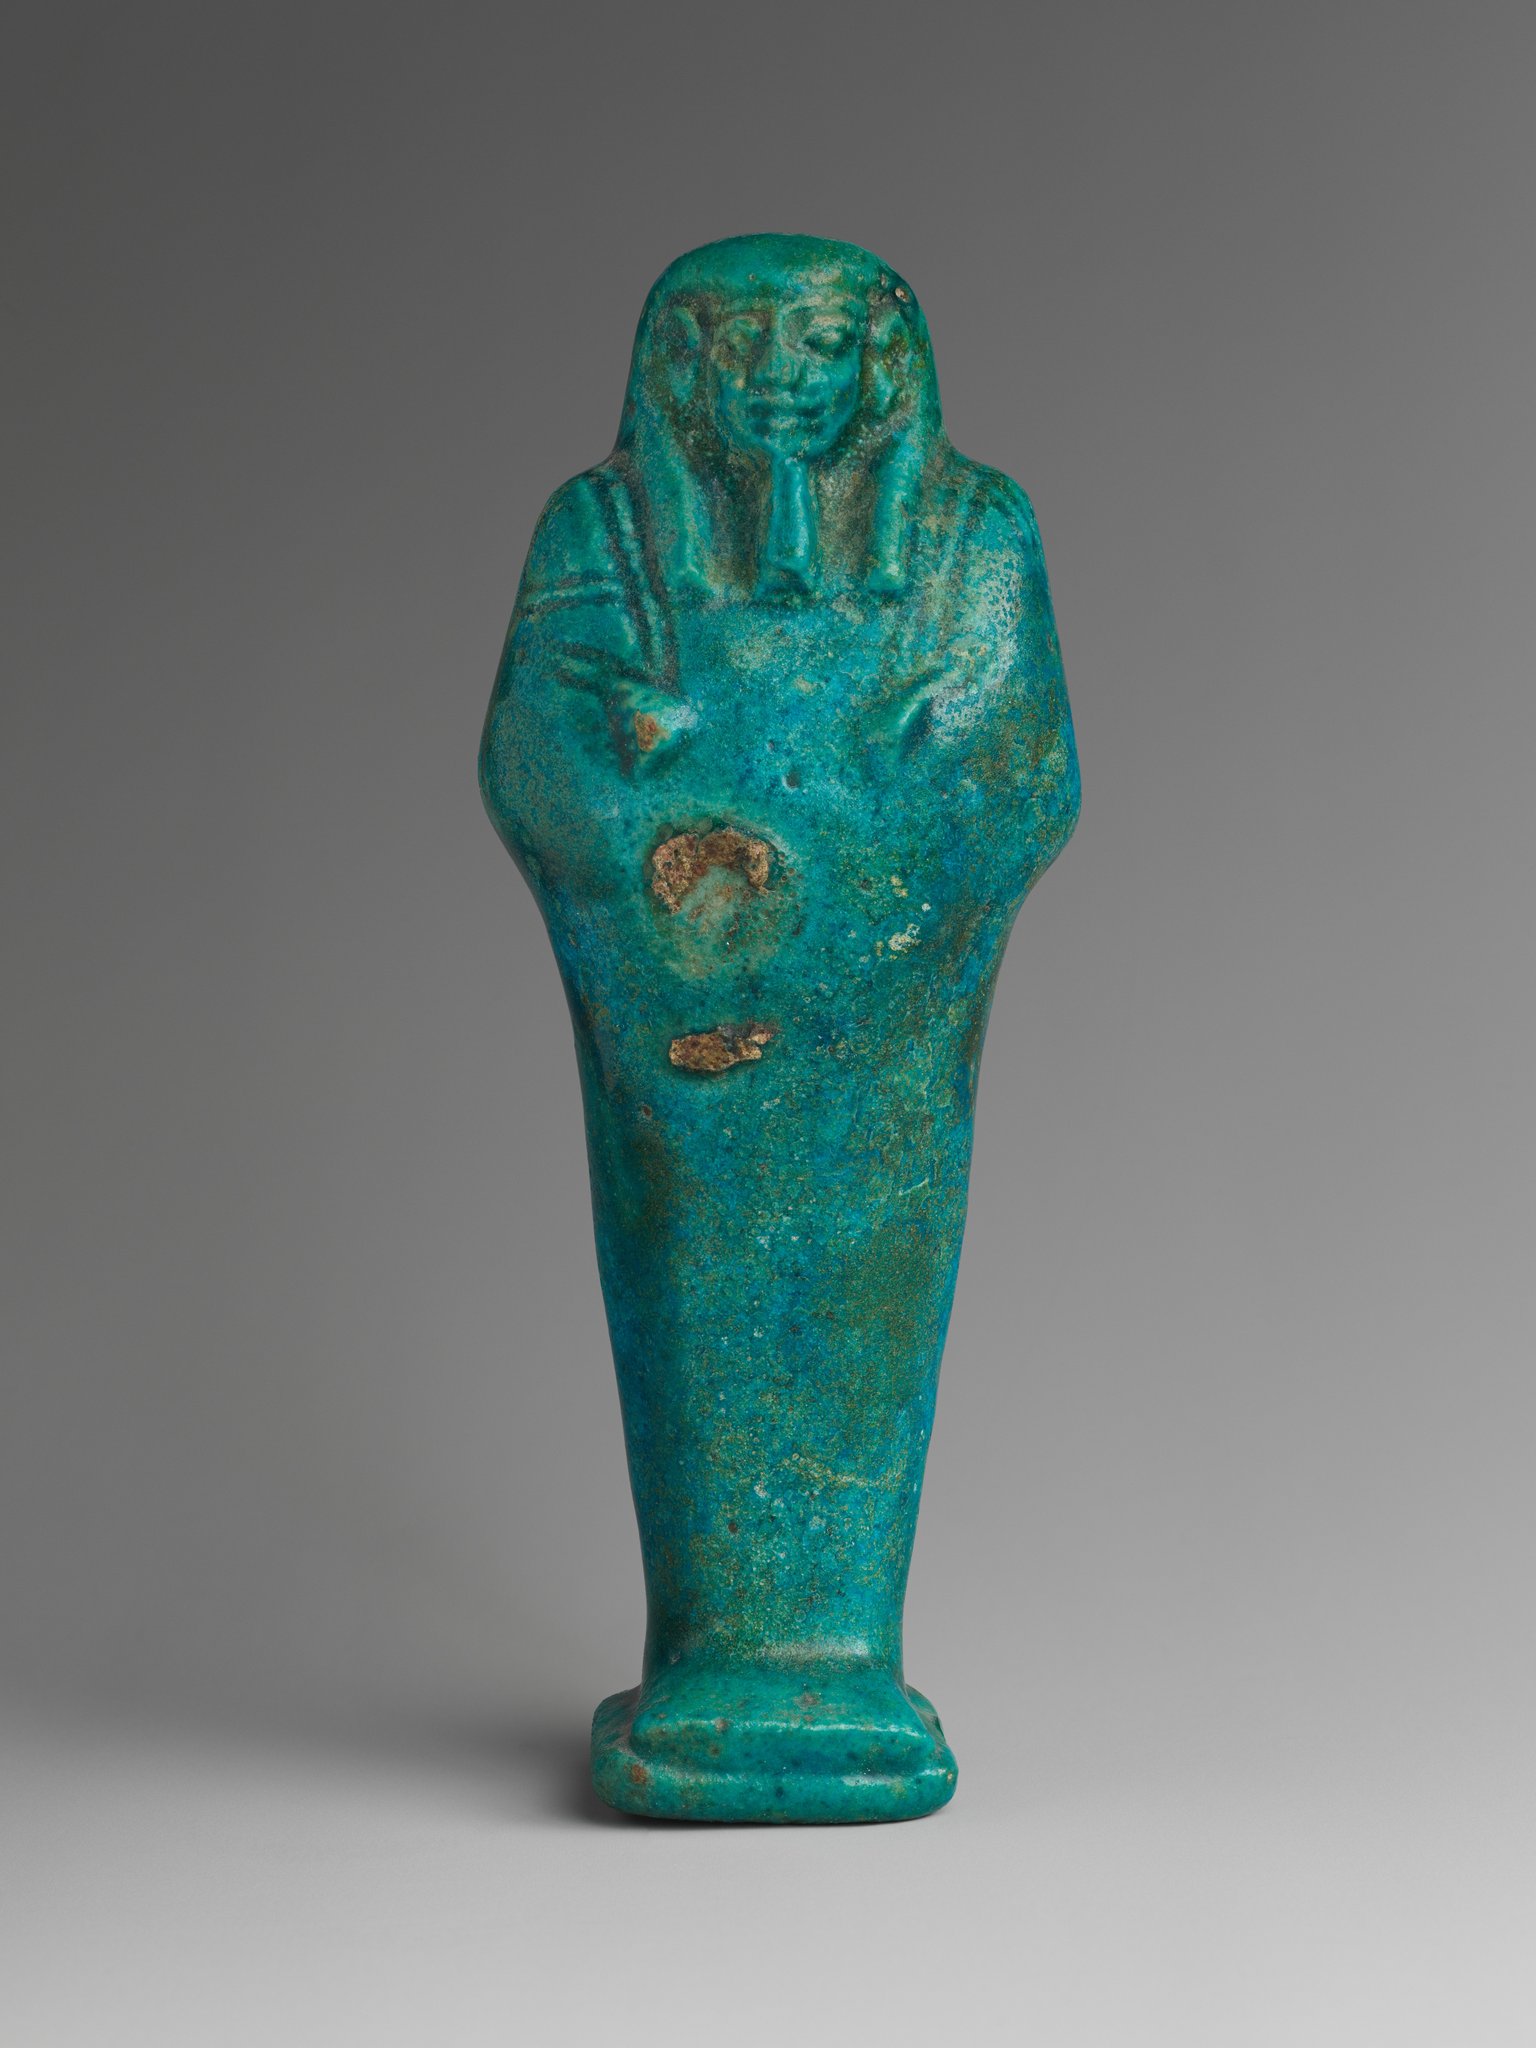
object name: shabti, djedhor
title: Shabti of Djedhor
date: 360-300 BCE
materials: faience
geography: egypt